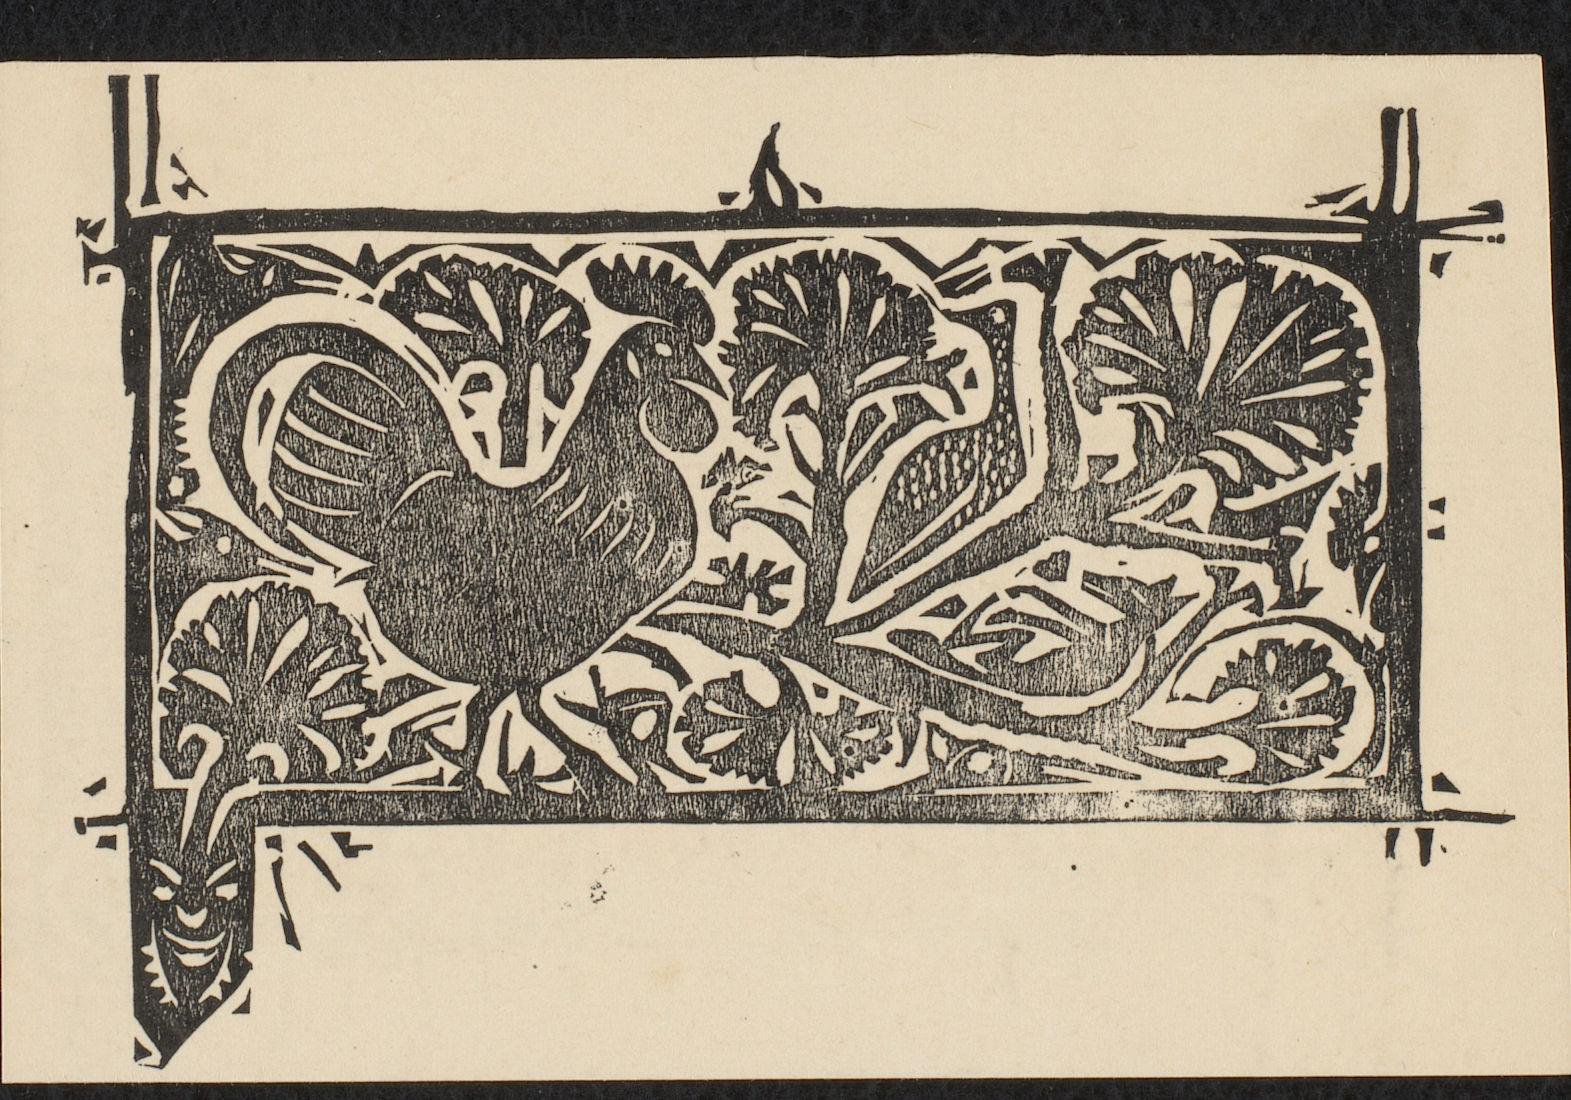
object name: print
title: Titelhoofd met een haan en dieren verborgen in struiken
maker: gerrit willem dijsselhof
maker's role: designer, draughtsman, print maker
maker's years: 1866-1924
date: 1893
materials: paper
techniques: galvanoplasty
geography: haarlem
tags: ornaments ~ art, fowl (cock, hen, chicken, etc.), beasts of prey, predatory animals: fox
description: Sluitvignet uit: Crane, Walter. Kunst en samenleving. [Vertaald uit het Engels door] Jan Veth. Amsterdam: Scheltema & Holkema's Boekhandel, 1894 [1893], p. 8. Later zijn deze afbeeldingen door de uitgever veelvuldig gebruikt voor andere uitgaven. Zie bijvoorbeeld RP-P-1969-415, een catalogus van de in 1894 bij Scheltema & Holkema's Boekhandel verkrijgbare publicaties.